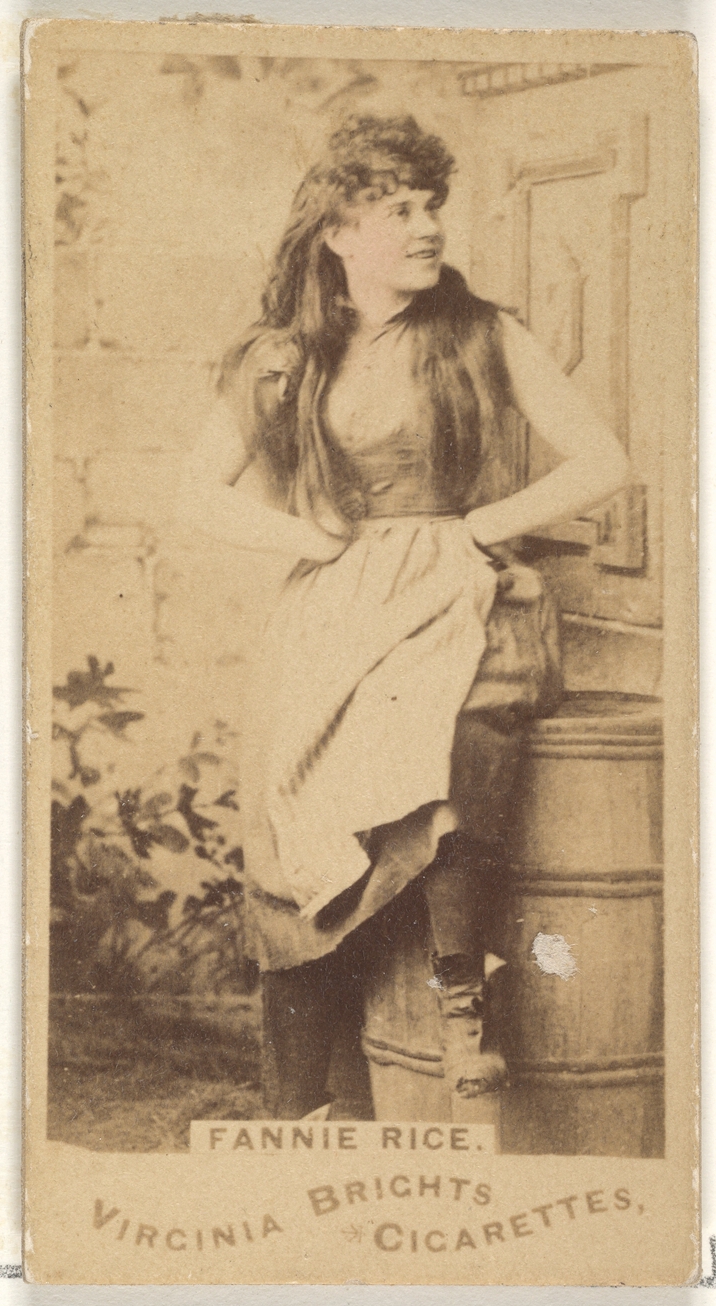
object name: photograph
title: Fanny Rice, from the Actors and Actresses series (N45, Type 1) for Virginia Brights Cigarettes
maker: allen & ginter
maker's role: publisher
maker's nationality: american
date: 1888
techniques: albumen silver print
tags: portraits,women,actresses